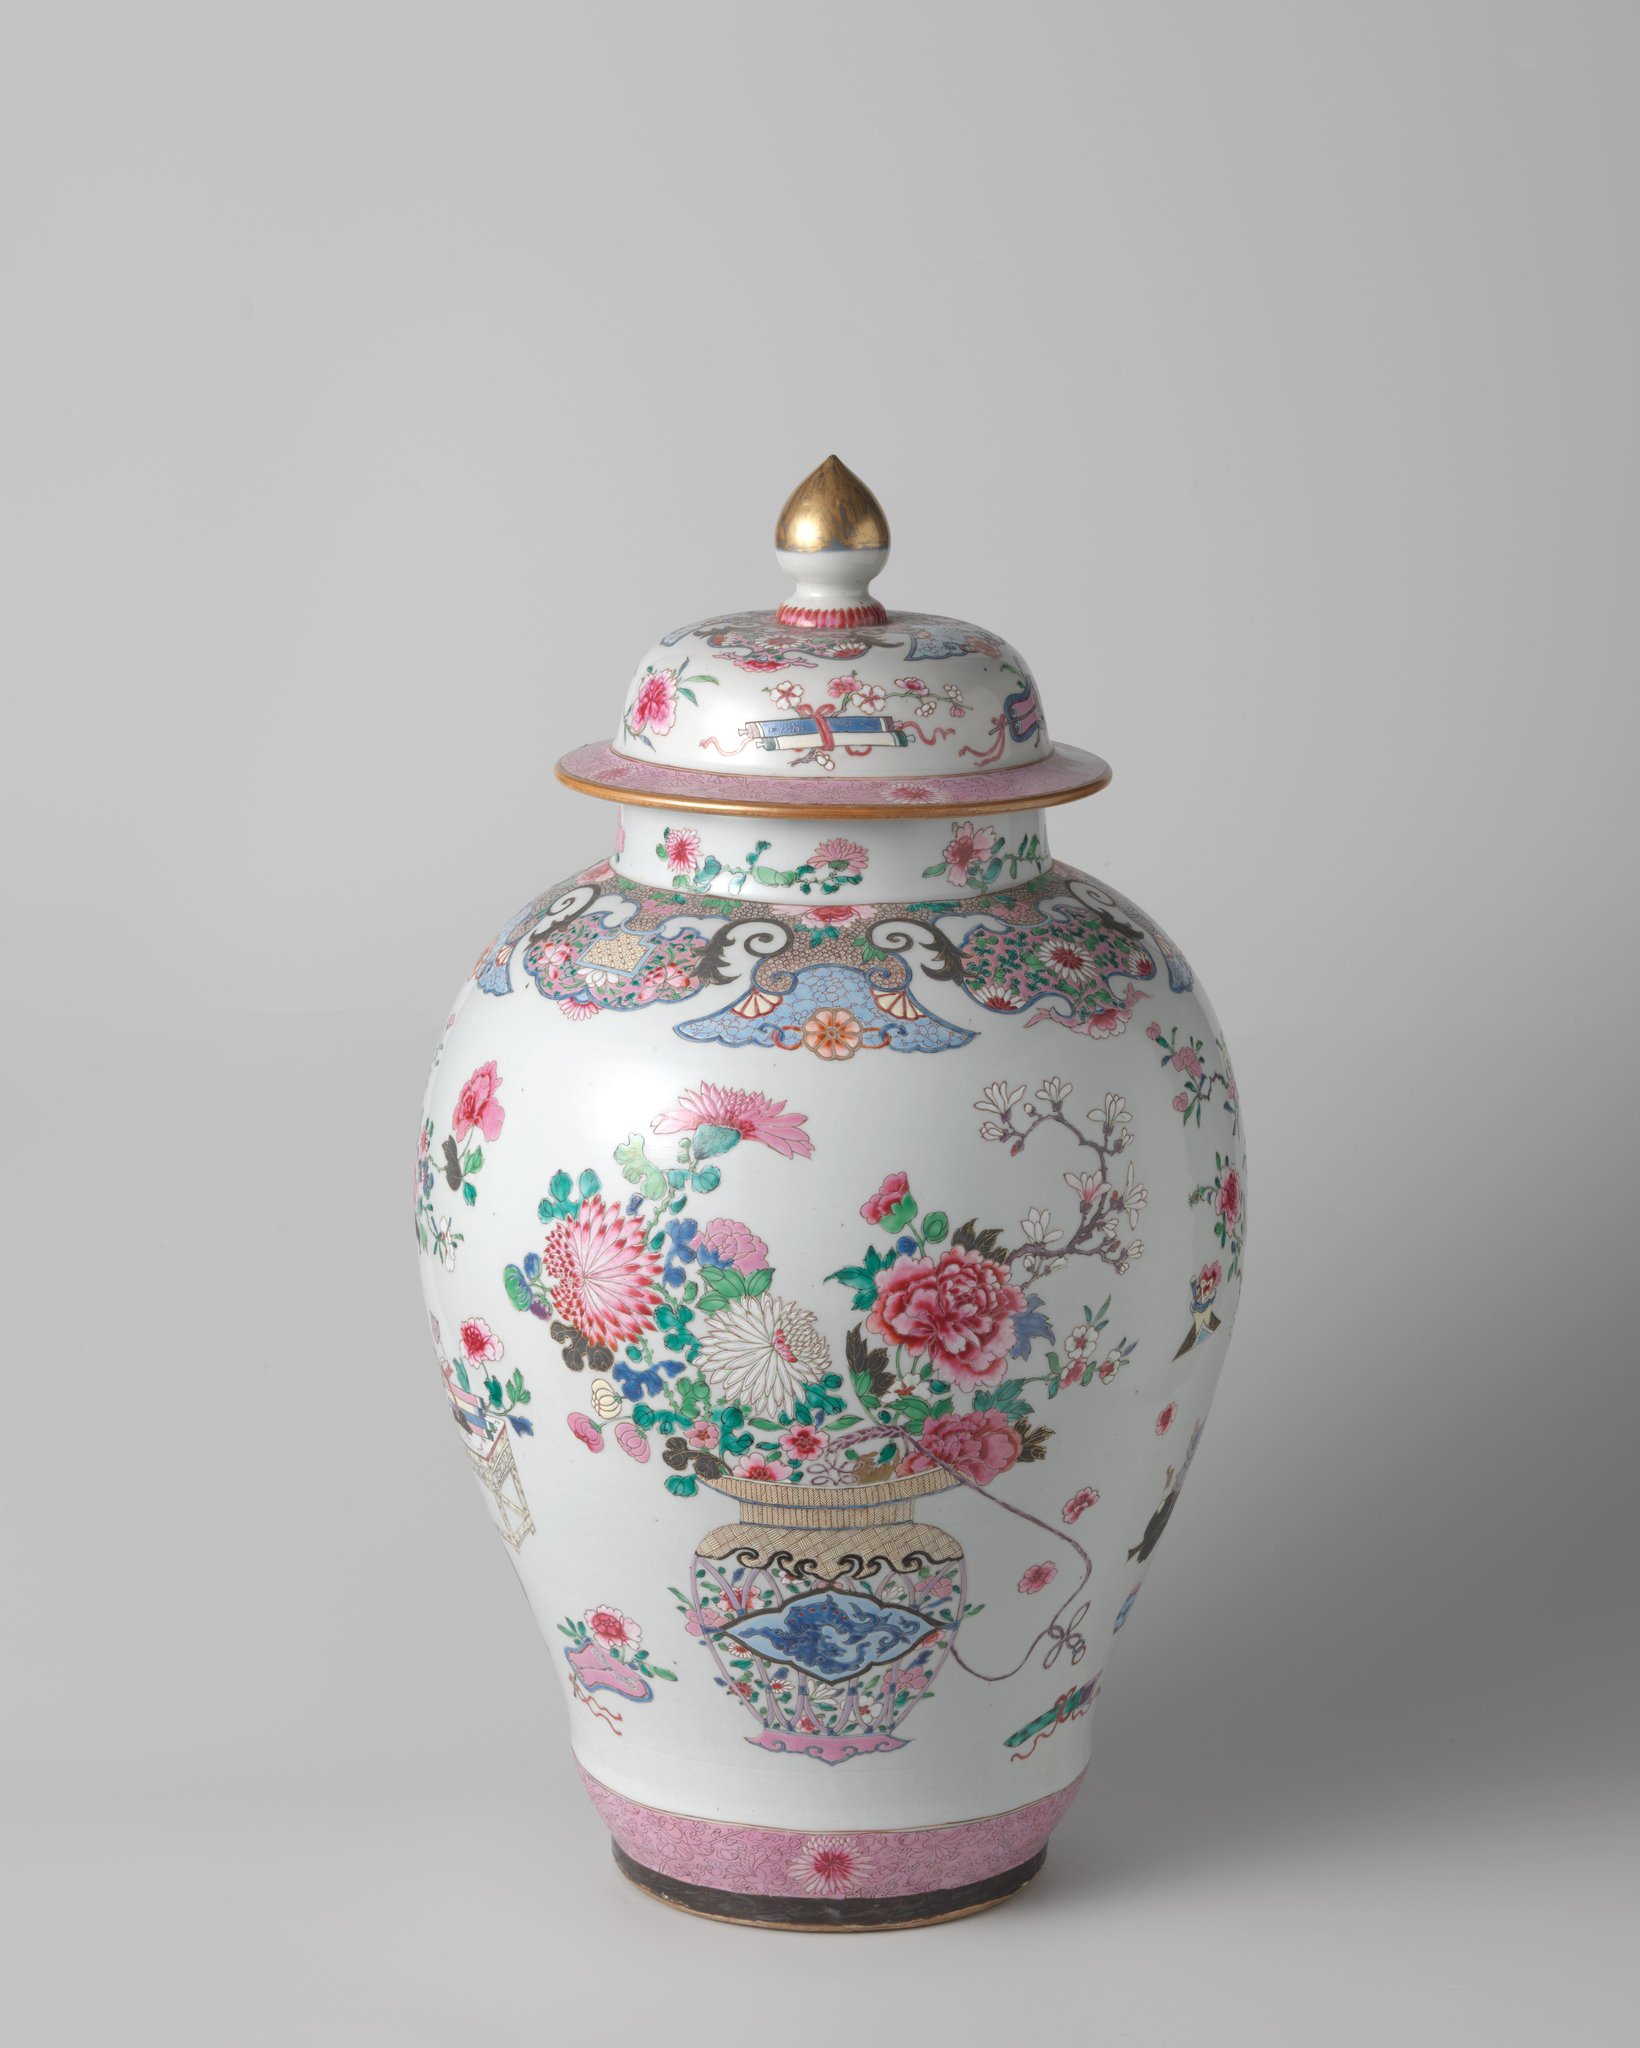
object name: covered jar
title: Ovoid covered jar with flower baskets and auspicious symbols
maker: Anonymous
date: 1850-1899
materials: cobalt, glaze, paint, porcelain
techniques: firing, gilding, turning, vitrification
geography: china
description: Deksel van eivormige dekselpot van porselein, beschilderd in onderglazuur blauw en op het glazuur in blauw, rood, roze, groen, zwart en goud. Op de wand geluksvoorwerpen (tafel met rollen, ruyi-scepter, waaier, qin, wierookbrander, kom met paddestoelen (lingzhi) en rollen). Op de schouder een onregelmatige band met pioenranken op 'kikkerdril', bladranken, chrysantranken, bloemrozetten en perzikbloesem 'crackled ice'. Op de rand een band met chrysantranken. Dekselknop goud beschilderd. Dekselpot is onderdeel van kaststel AK-RBK-15919. Famille rose.